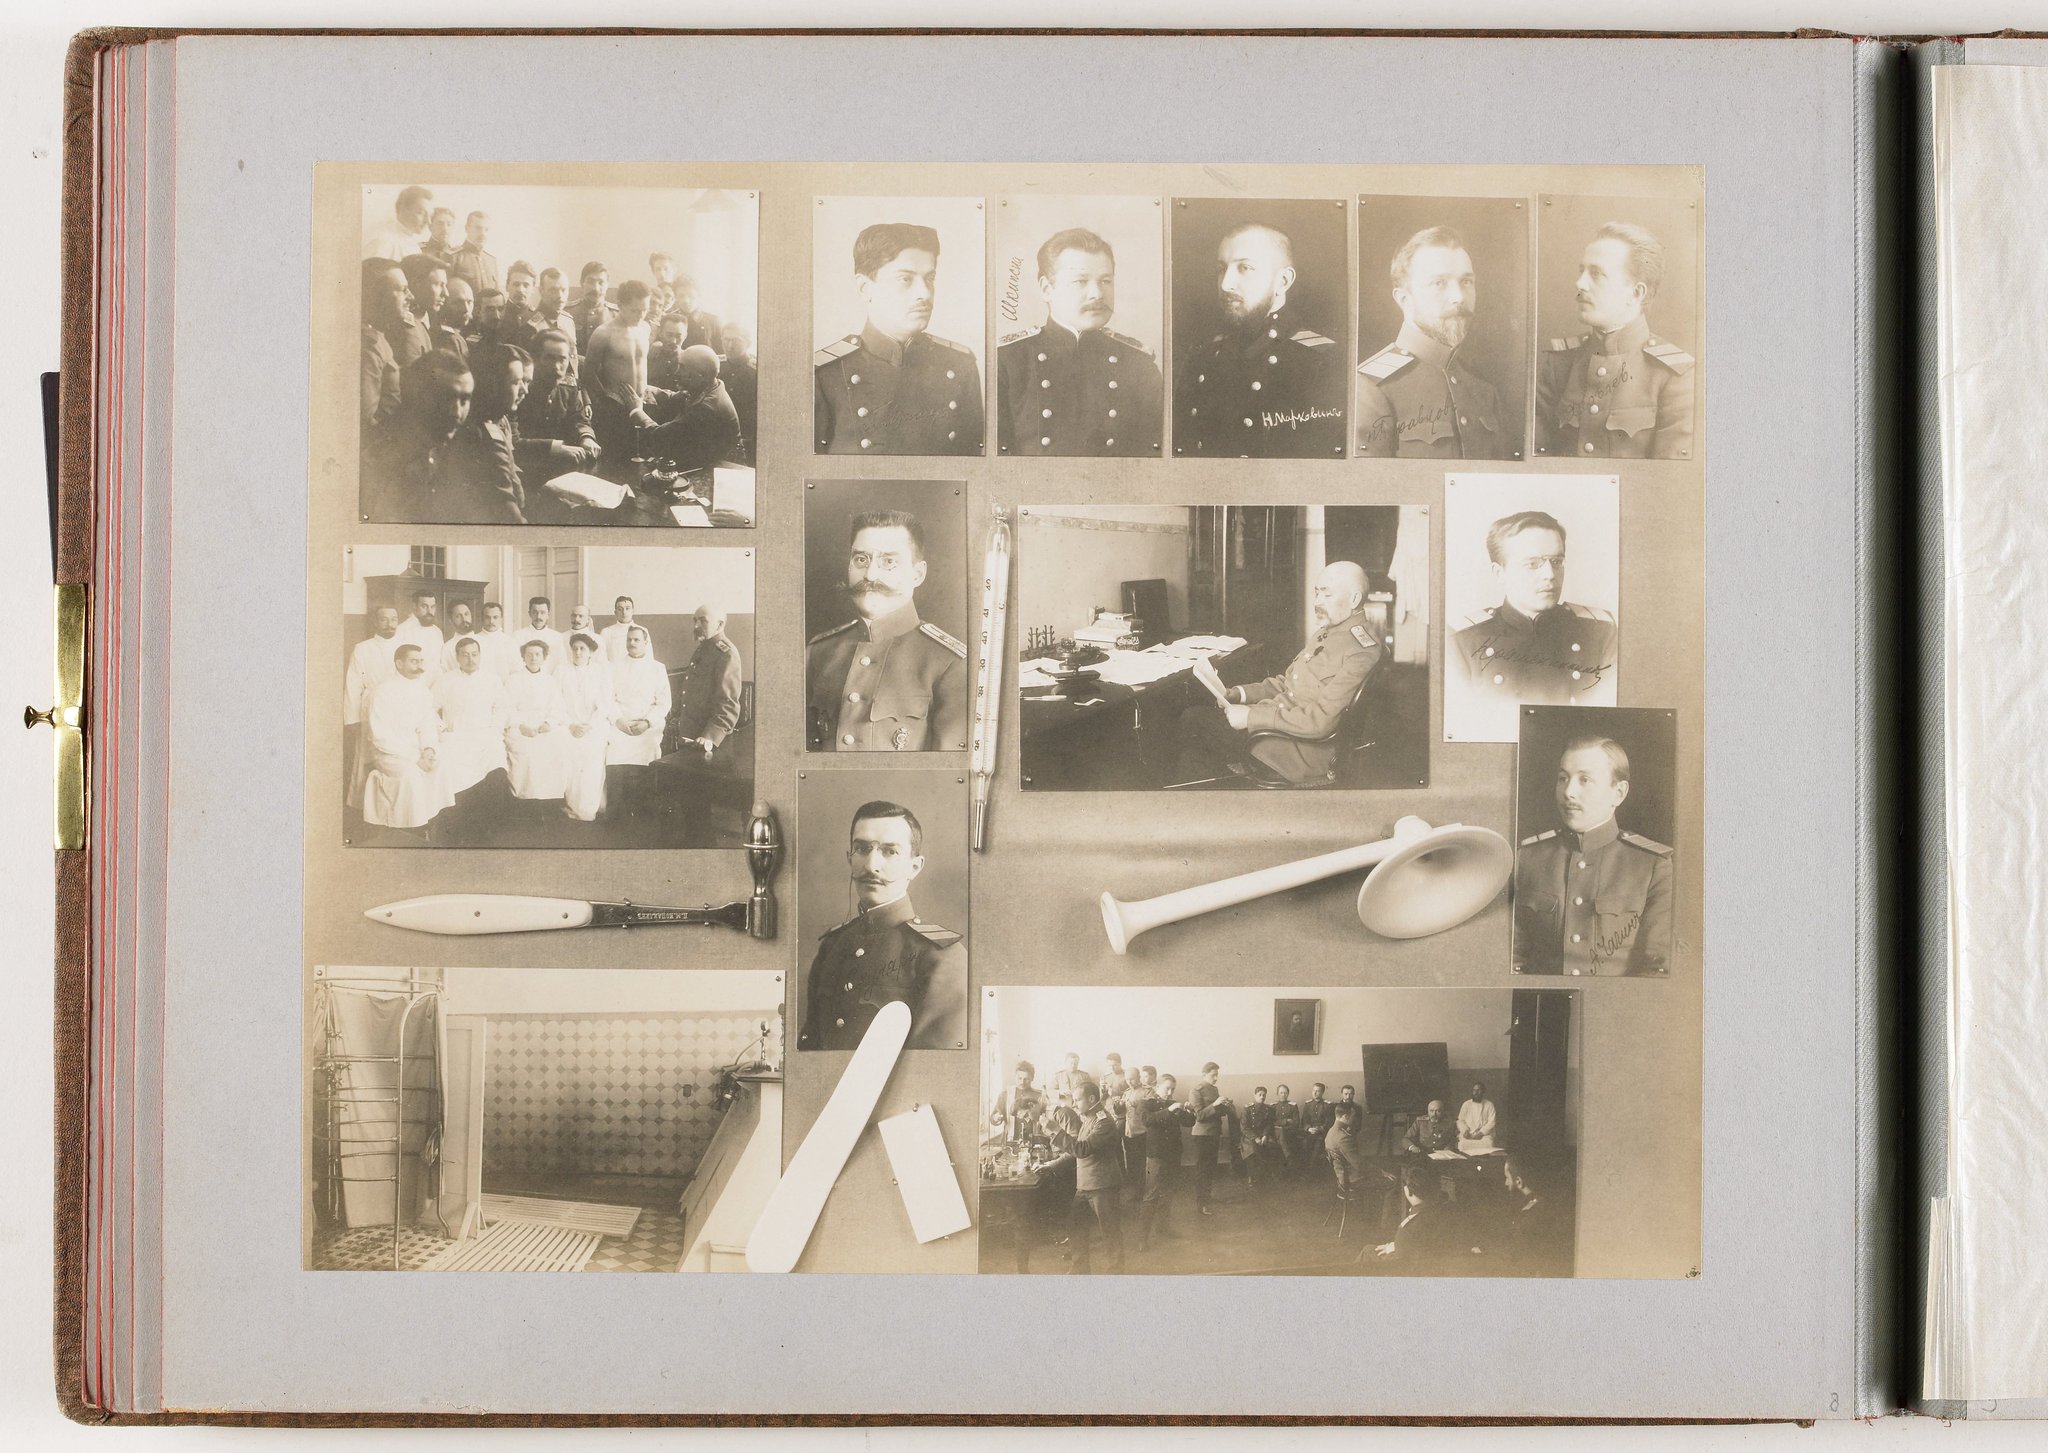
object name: photograph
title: Compositie van veertien foto's van personen en onderwijs aan de Keizerlijke Militair-Medische Academie, gecombineerd met decoratie van medische instrumenten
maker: v. sabelskij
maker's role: fotograaf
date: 1913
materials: cardboard, paper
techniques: salted paper print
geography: sint-petersburg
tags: medical instruments, historical persons not known by name